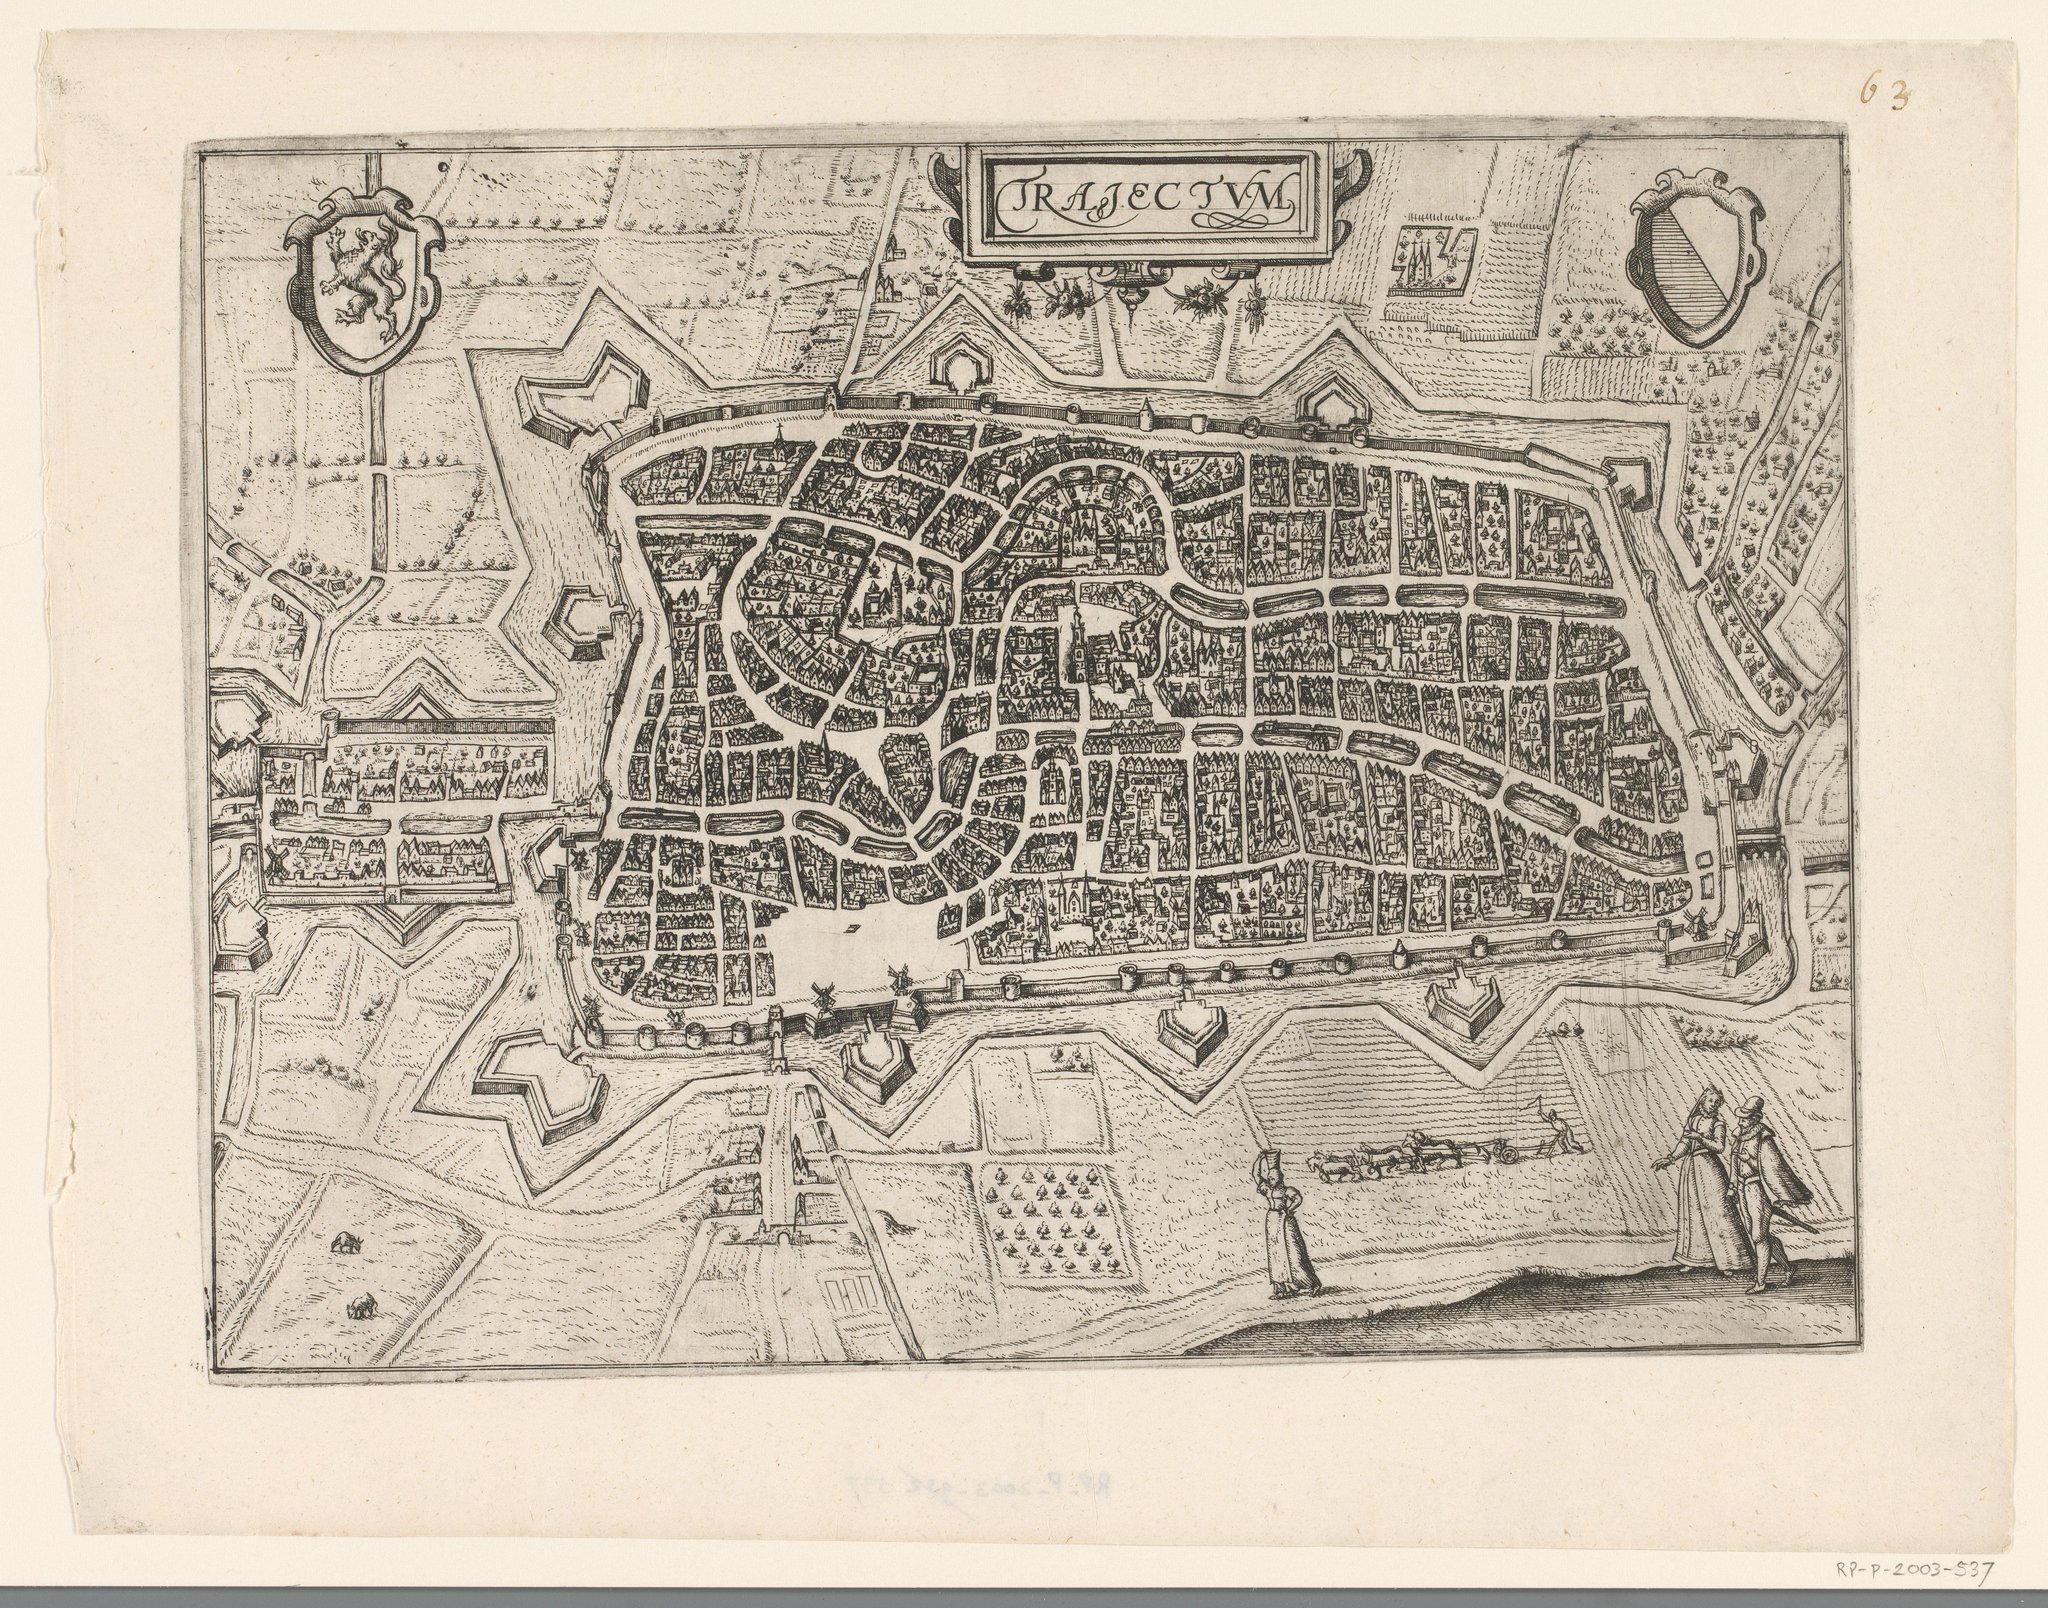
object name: print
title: Trajectum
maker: Anonymous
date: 1607-1609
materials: paper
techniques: etching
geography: southern netherlands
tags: maps of cities, utrecht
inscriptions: number: ‘63’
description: Plattegrond van de stad Utrecht. Midden boven een cartouche met de Latijnse titel, links het wapen van Holland, rechts het stadswapen. Onderaan een man en een vrouw en een tweede vrouw lopend op een weg. Onderdeel van de verzameling kaarten genomen uit een latere editie van: Descrittione di tutti i Paesi Bassi van Lodovico Guicciardini.